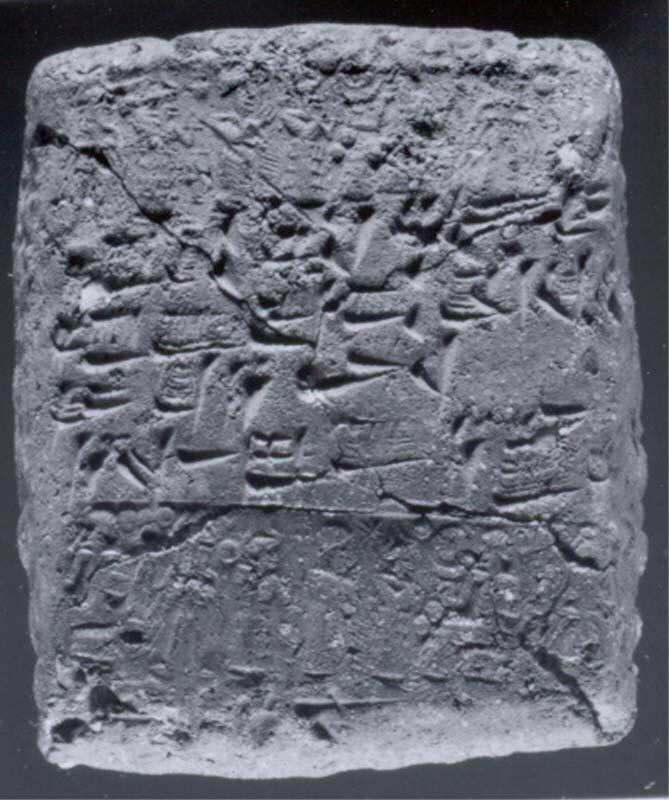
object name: cuneiform tablet case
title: Cuneiform tablet case impressed with three cylinder seals, for cuneiform tablet 66.245.19a: legal decision by appointed judges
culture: assyrian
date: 2000-1801 BCE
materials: clay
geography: anatolia